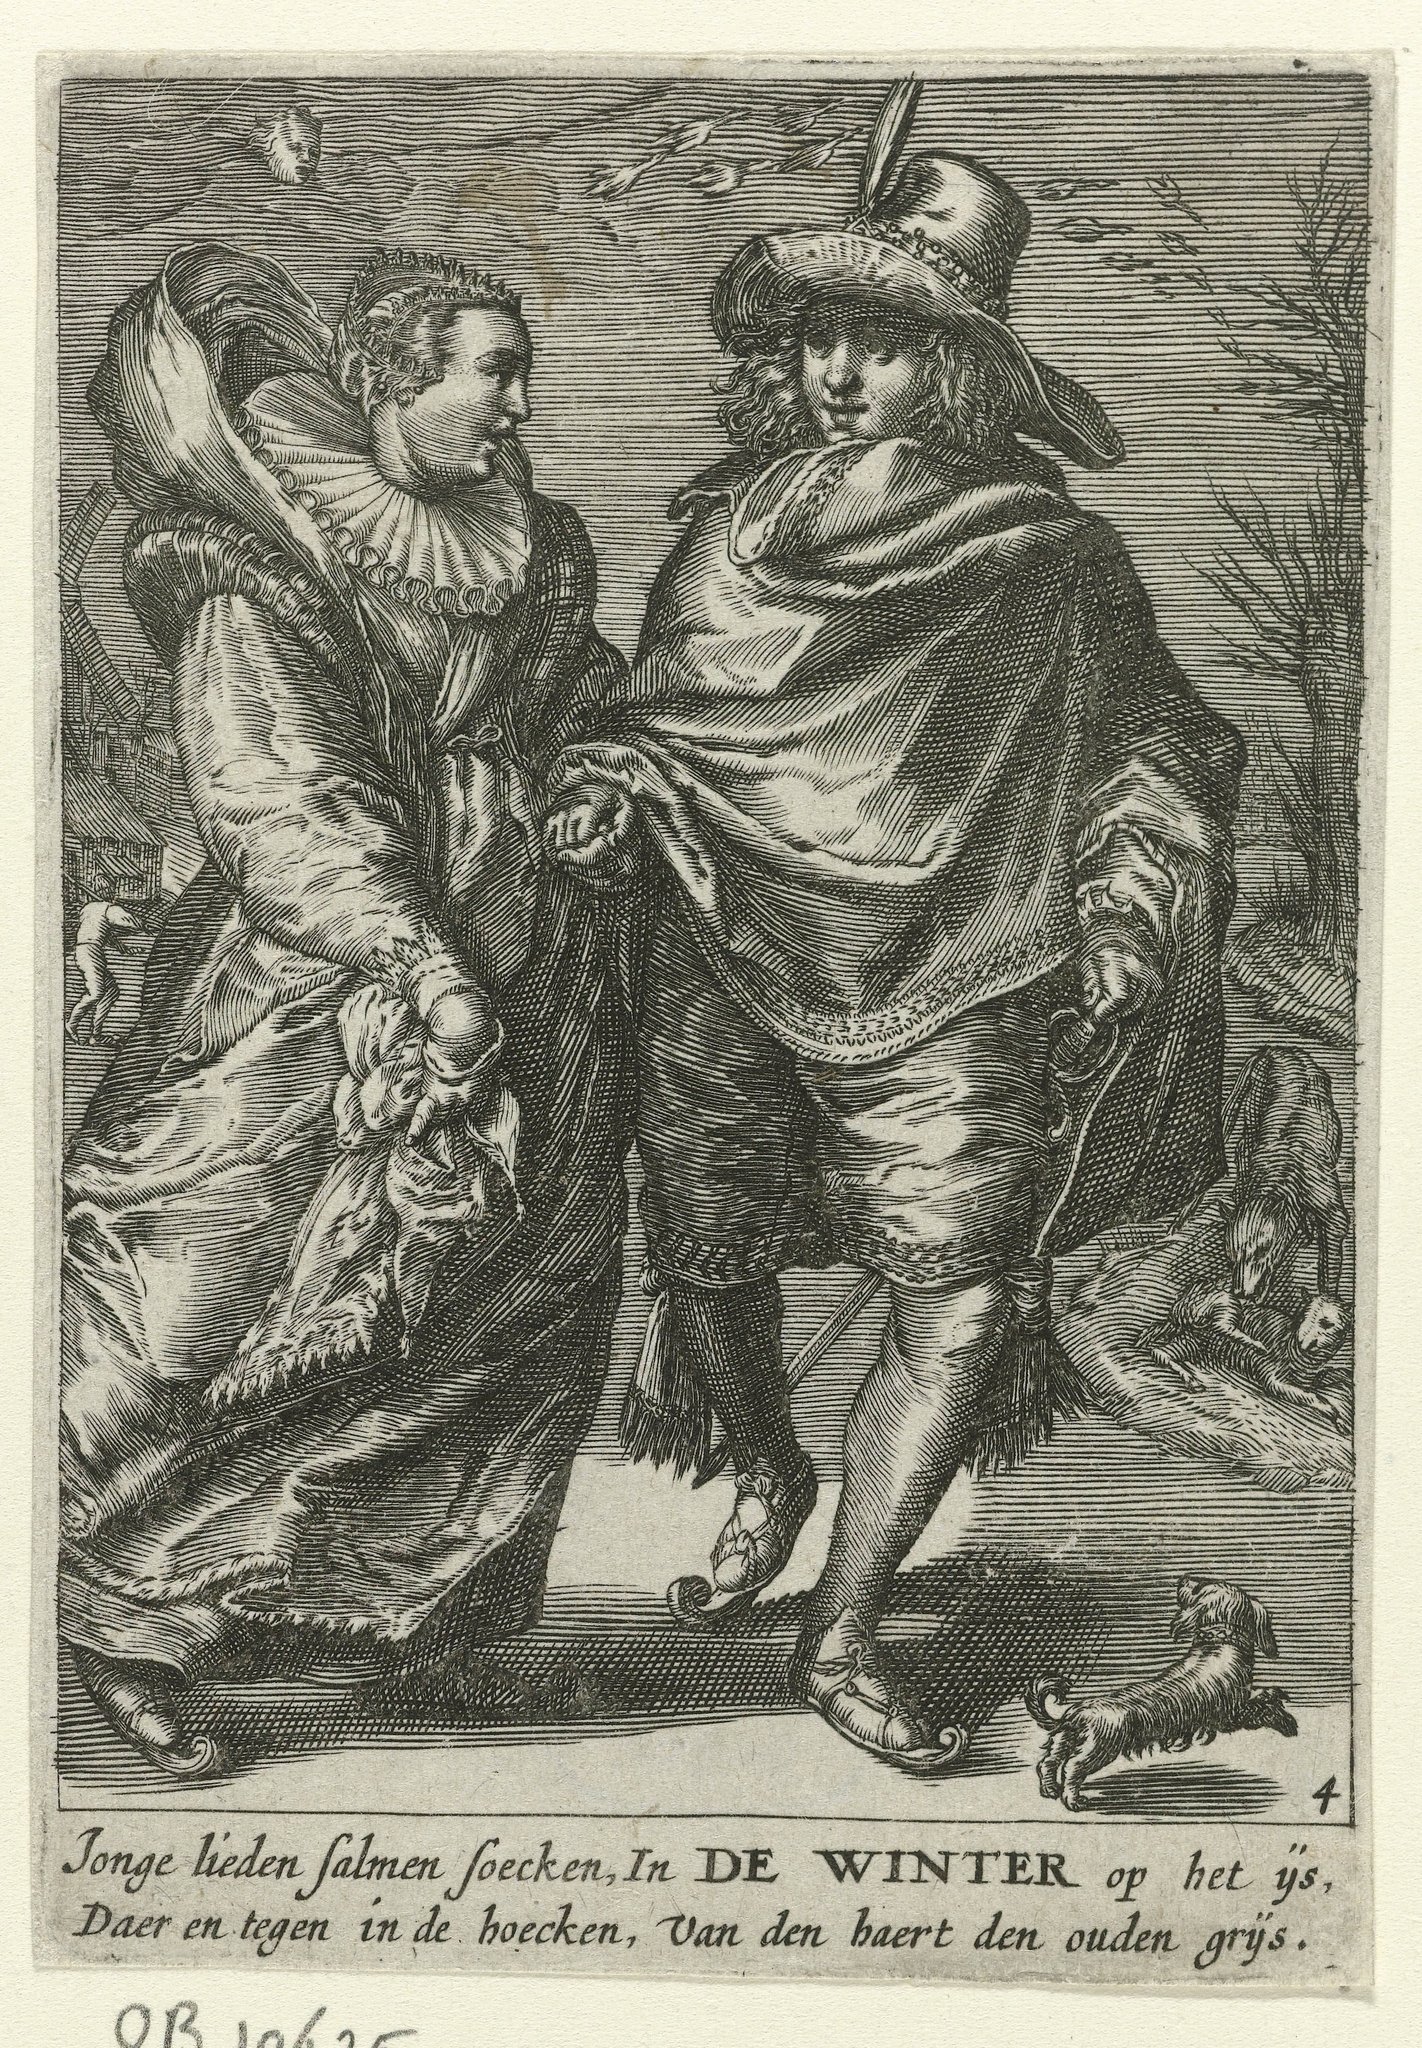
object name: print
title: De Winter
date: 1601-1651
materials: paper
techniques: engraving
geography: northern netherlands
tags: winter, 'hyems'; 'inverno' (ripa), clothes, costume (+ women's clothes), clothes, costume (+ men's clothes), skates (winter sports)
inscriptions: collector's mark: Lugt 2228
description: Jongeman en jonge vrouw, schaatsend op het ijs, elegant gekleed volgens de mode van ca. 1600. Voor hun voeten loopt een hondje.